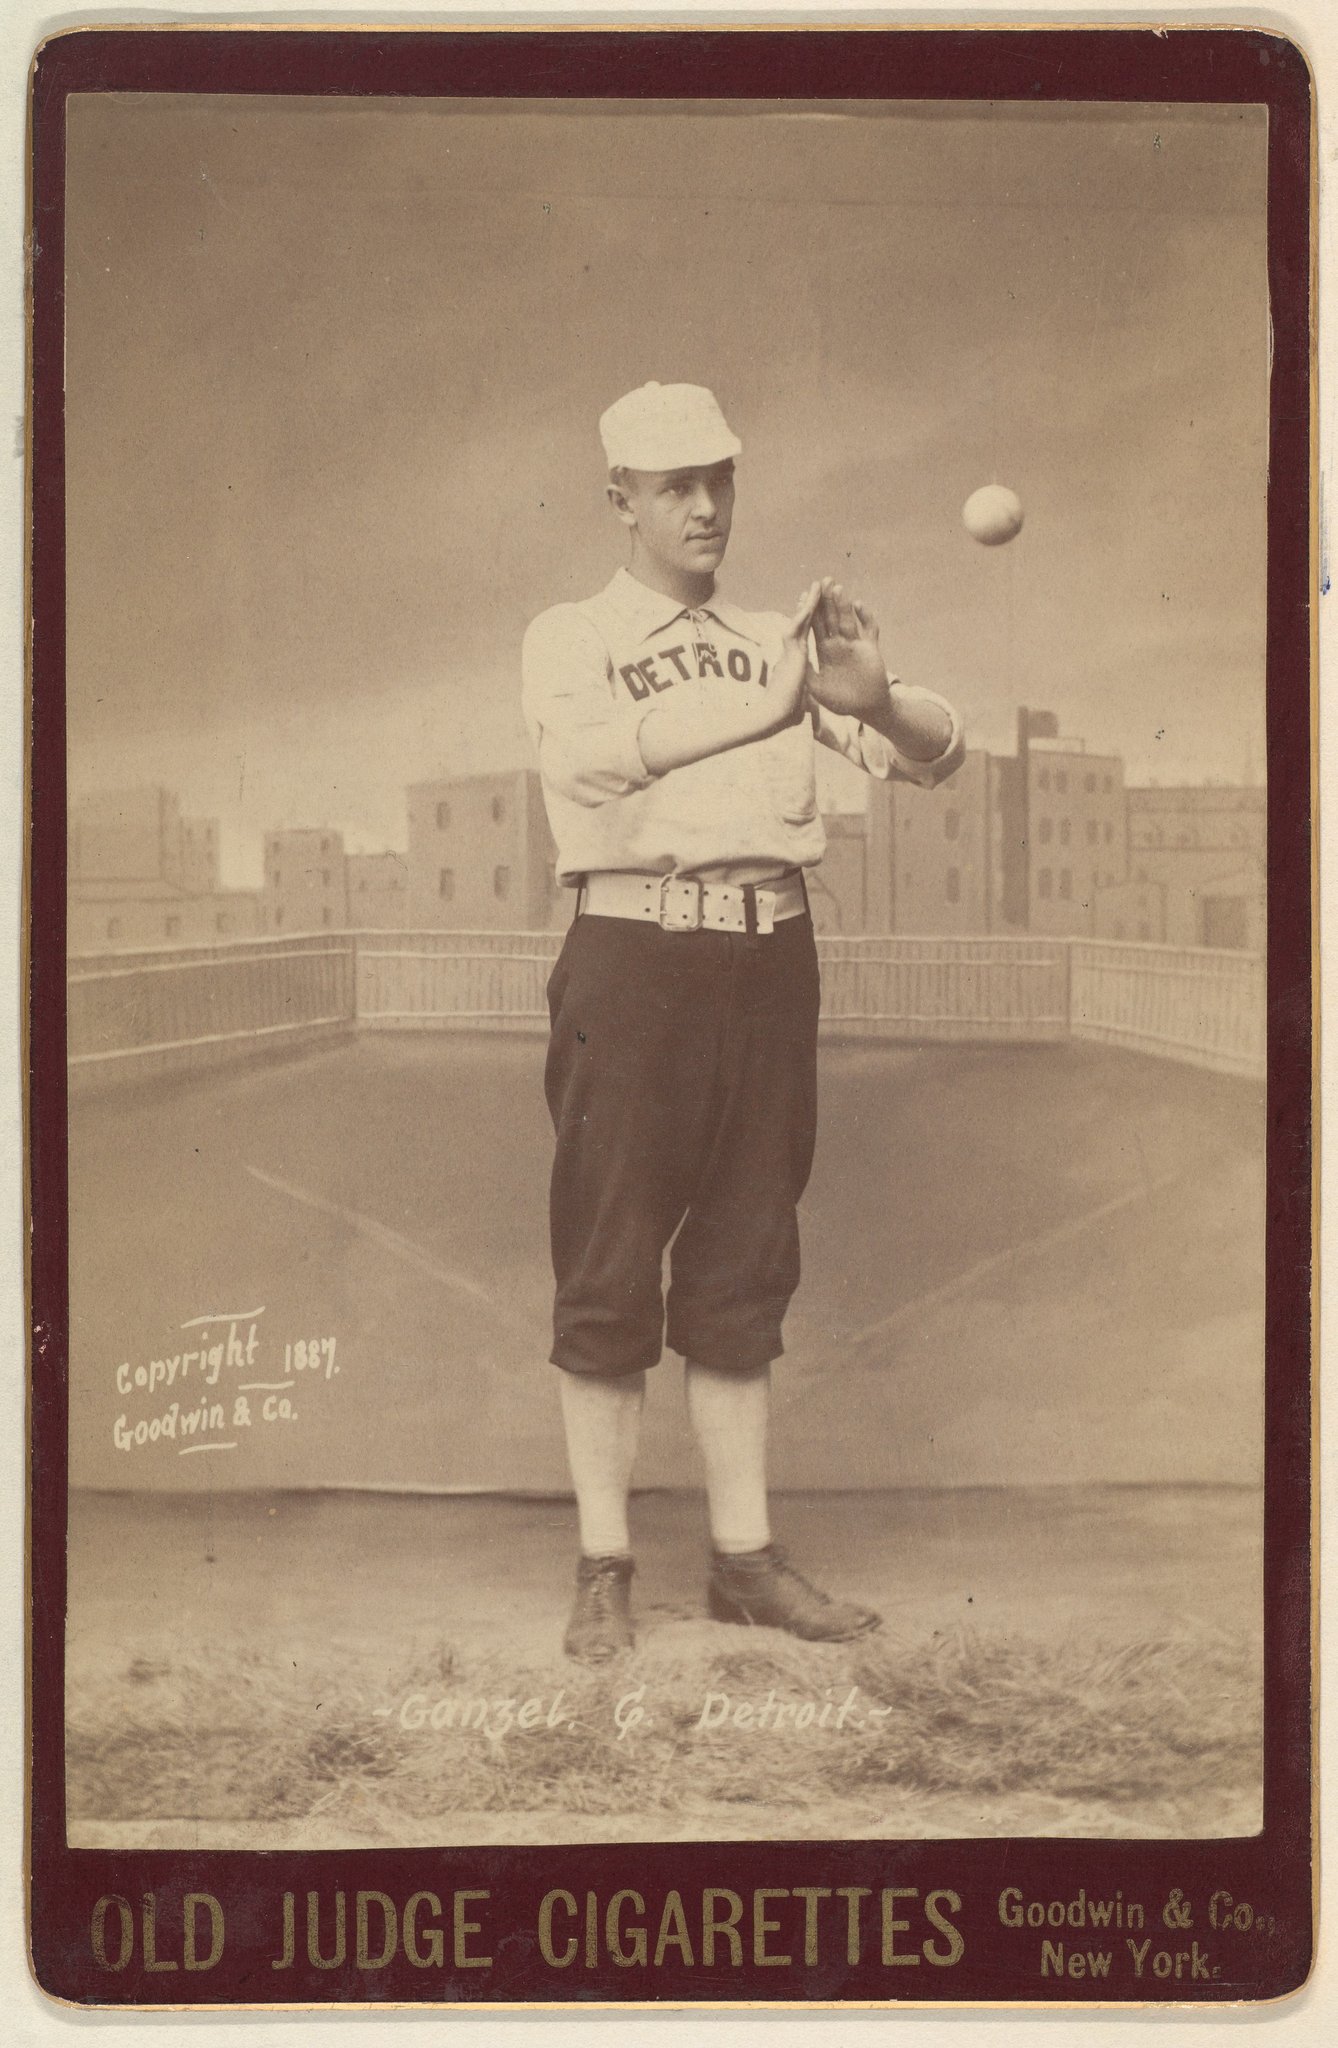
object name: baseball card, photograph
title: Ganzel, Catcher, Detroit, from the series Old Judge Cigarettes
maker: goodwin & company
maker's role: publisher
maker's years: 1850-1950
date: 1887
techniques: albumen print, photography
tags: men,portraits,baseball,athletes